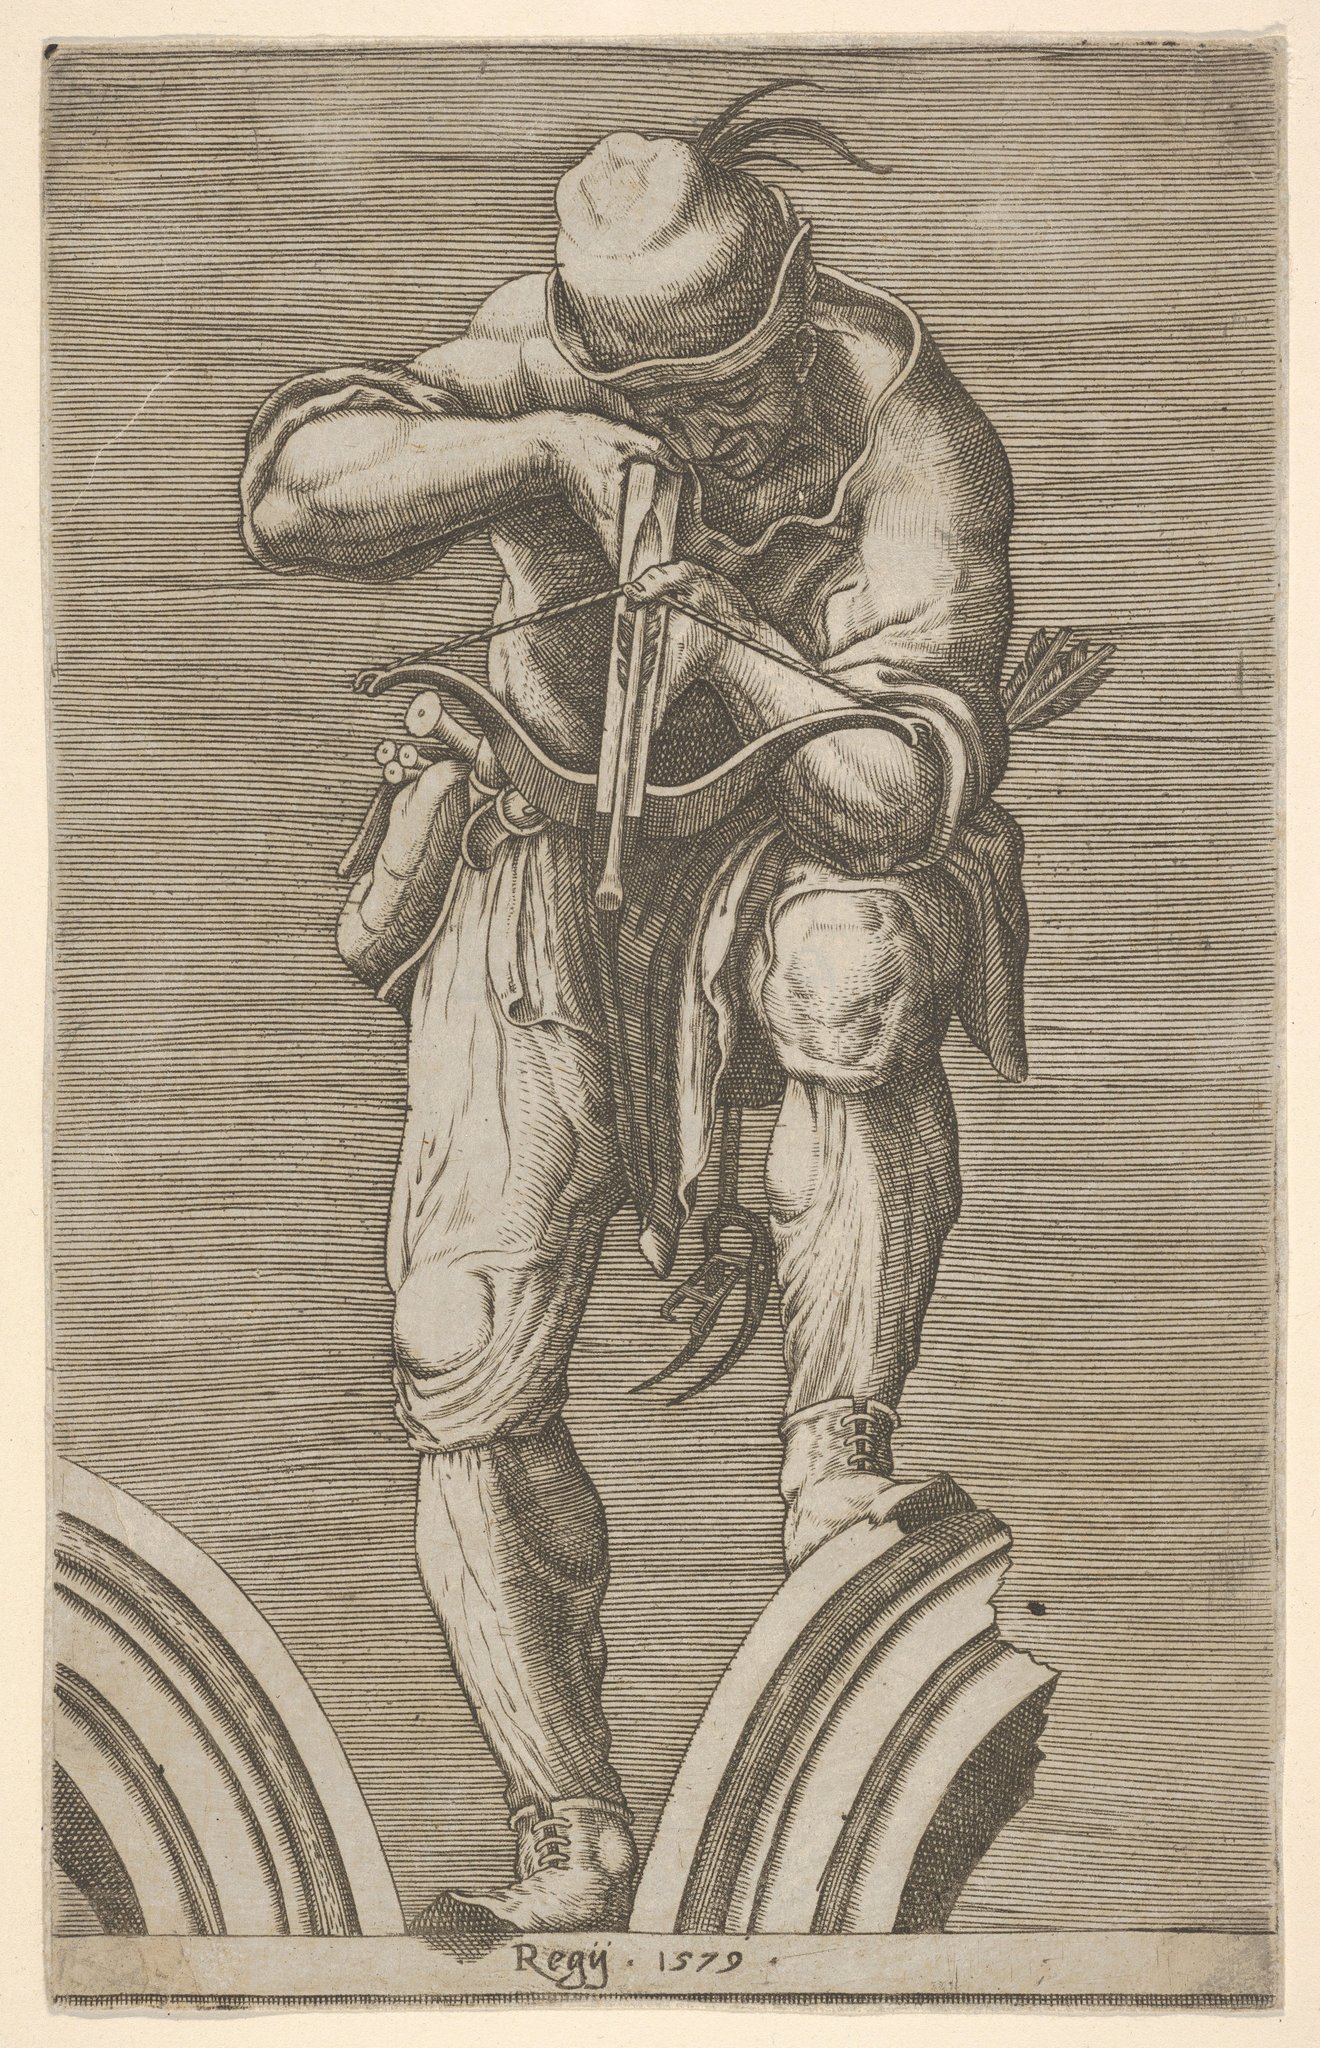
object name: print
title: A Man Shooting a Crossbow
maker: cherubino alberti (zaccaria mattia)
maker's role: artist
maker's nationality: italian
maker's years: 1553-1615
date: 1579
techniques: engraving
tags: bow and arrow,men